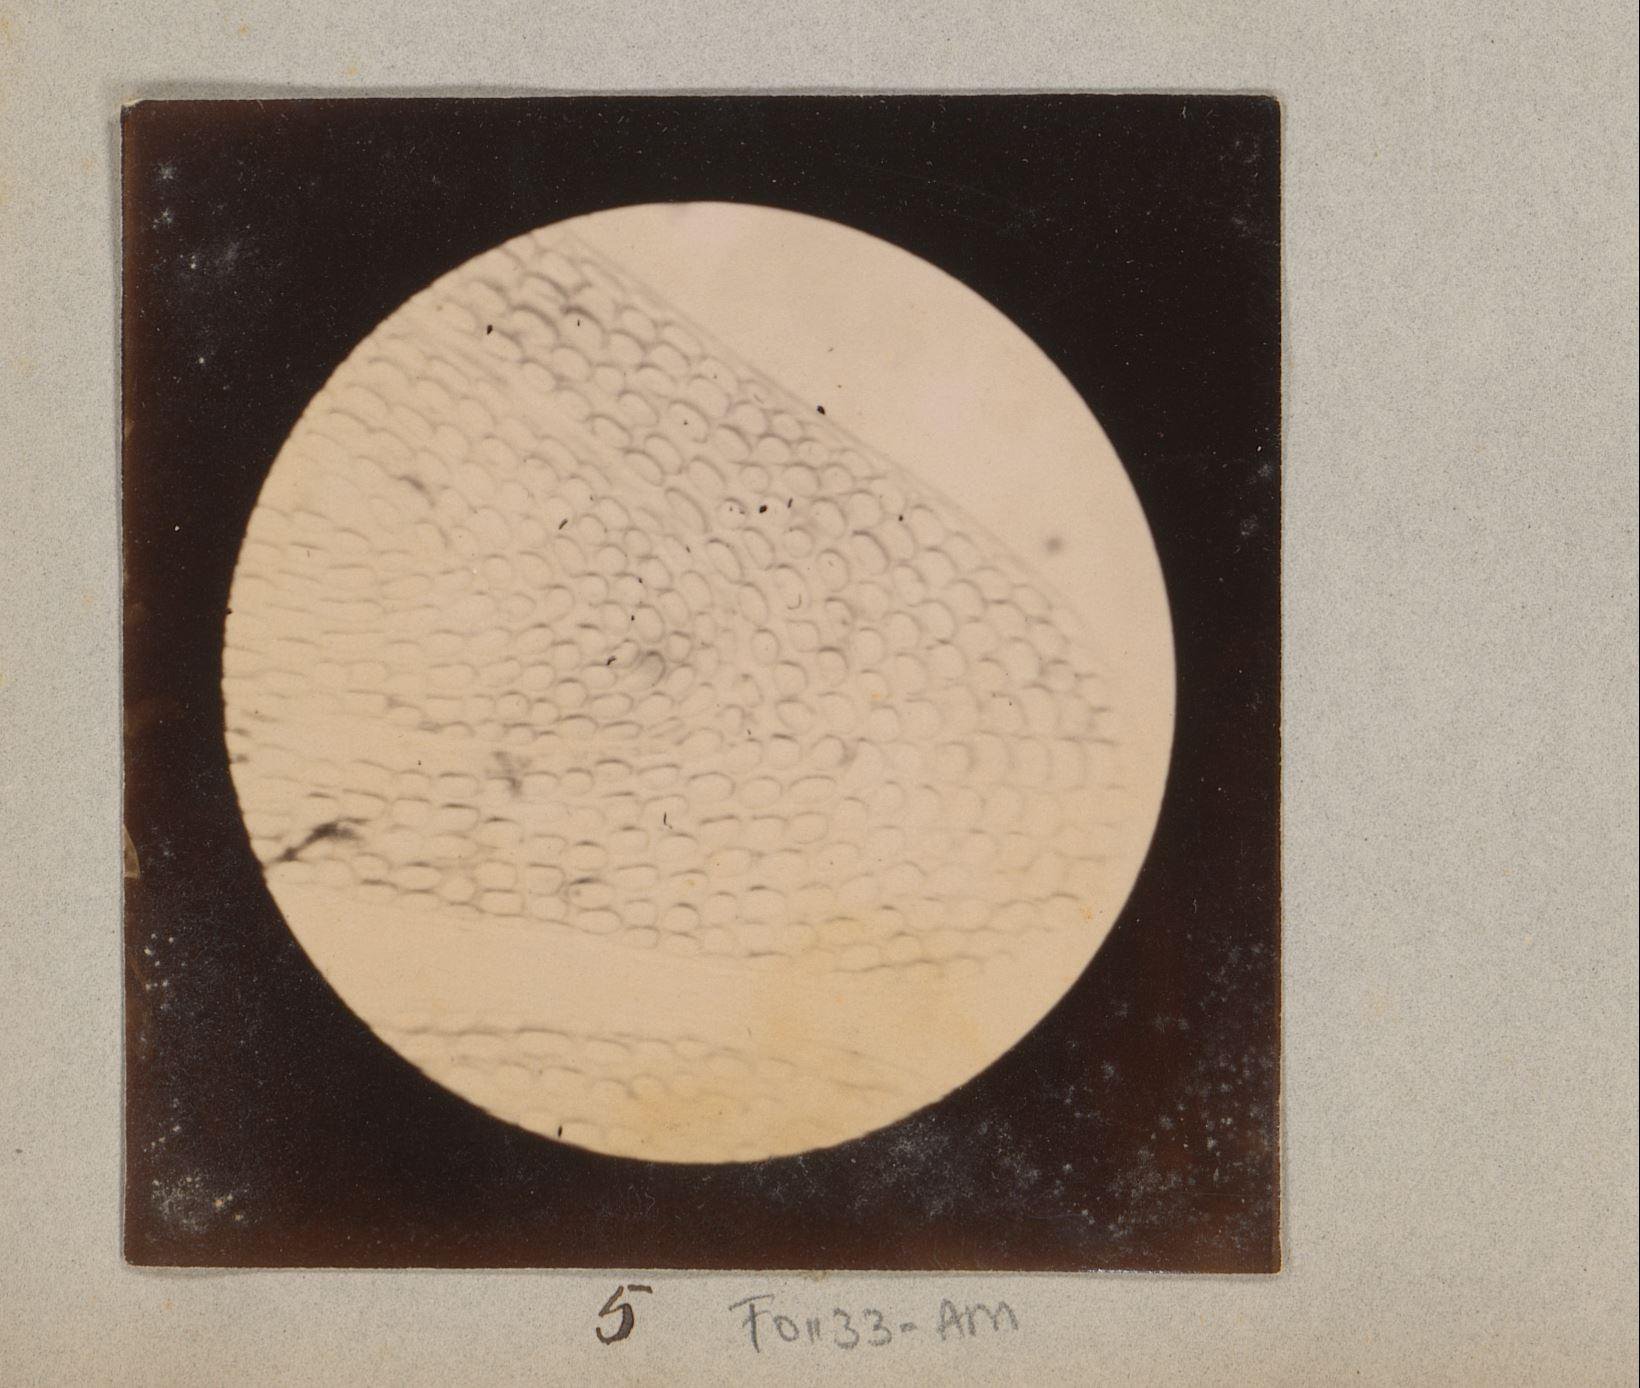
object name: photograph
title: Microscopische opname van schub van een paling, 25 keer vergroot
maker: marinus pieter filbri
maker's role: instrument maker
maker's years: 1852-1917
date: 1887-1888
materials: paper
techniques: albumen print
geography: netherlands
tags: eels: eel, netherlands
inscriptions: number: ‘5’, inscription: ‘No. 5. Benaming Schub van een paling, vergroot 25 x, Pose 3 id, bemerking id. eigen prep.’